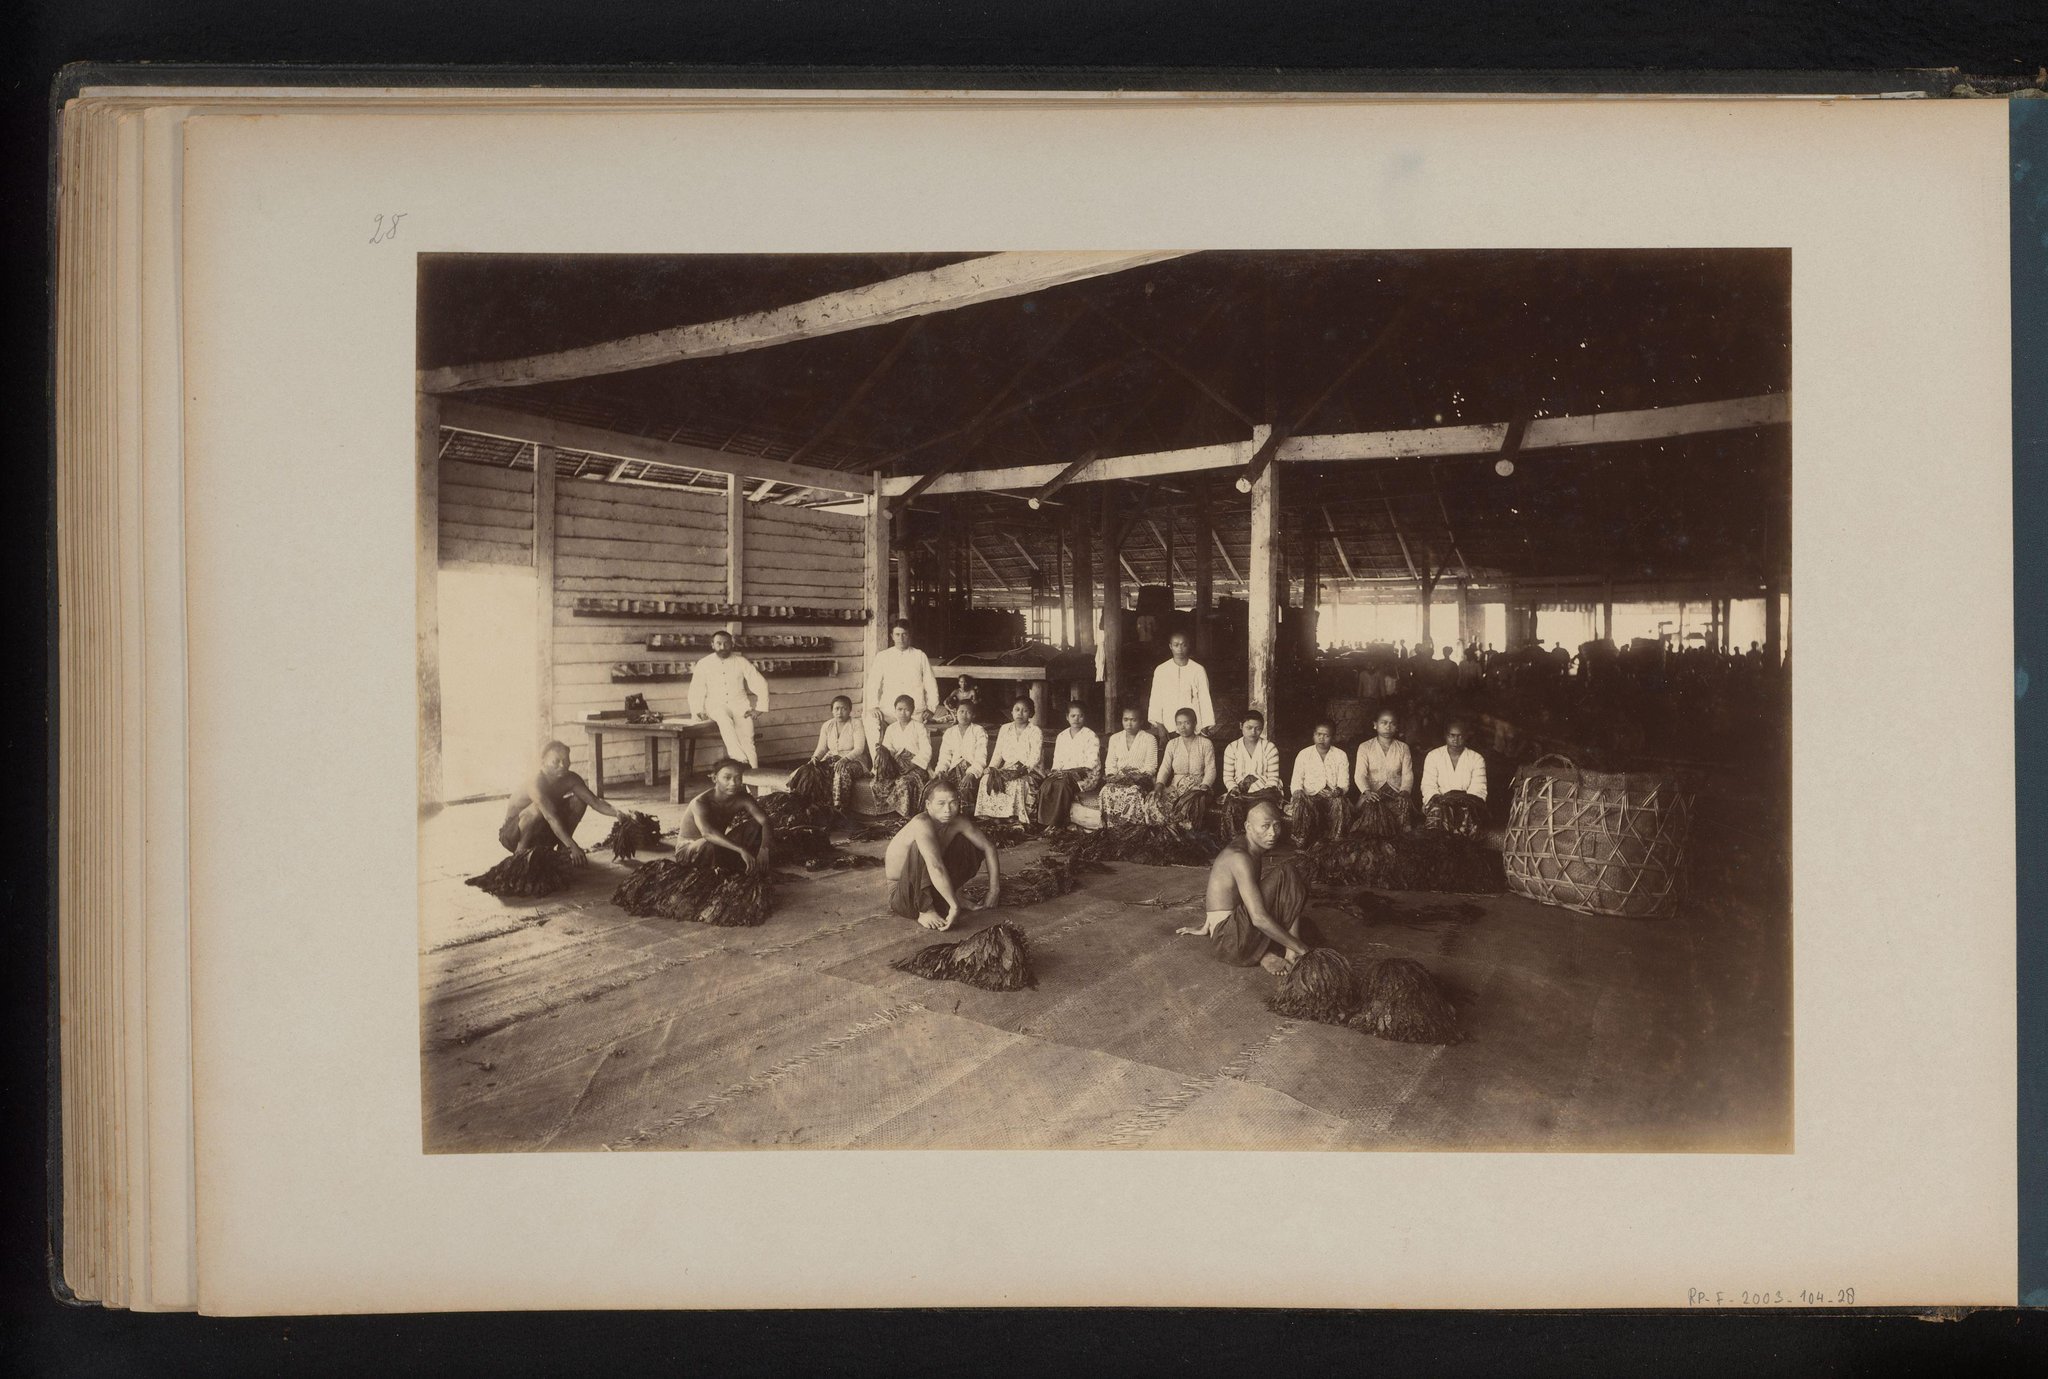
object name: album leaf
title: Koelies sorteren tabak op de onderneming Bekioen, Sumatra (Tabaksortieren in Bekioen)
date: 1890-1900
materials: cardboard, photographic support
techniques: albumen print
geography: sumatra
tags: plantation, sorting of products, working class, labourers, tobacco, sumatra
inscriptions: number: ‘28’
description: In de lijst van afbeeldingen wordt deze foto beschreven met de woorden "Tabaksortieren in Bekioen".